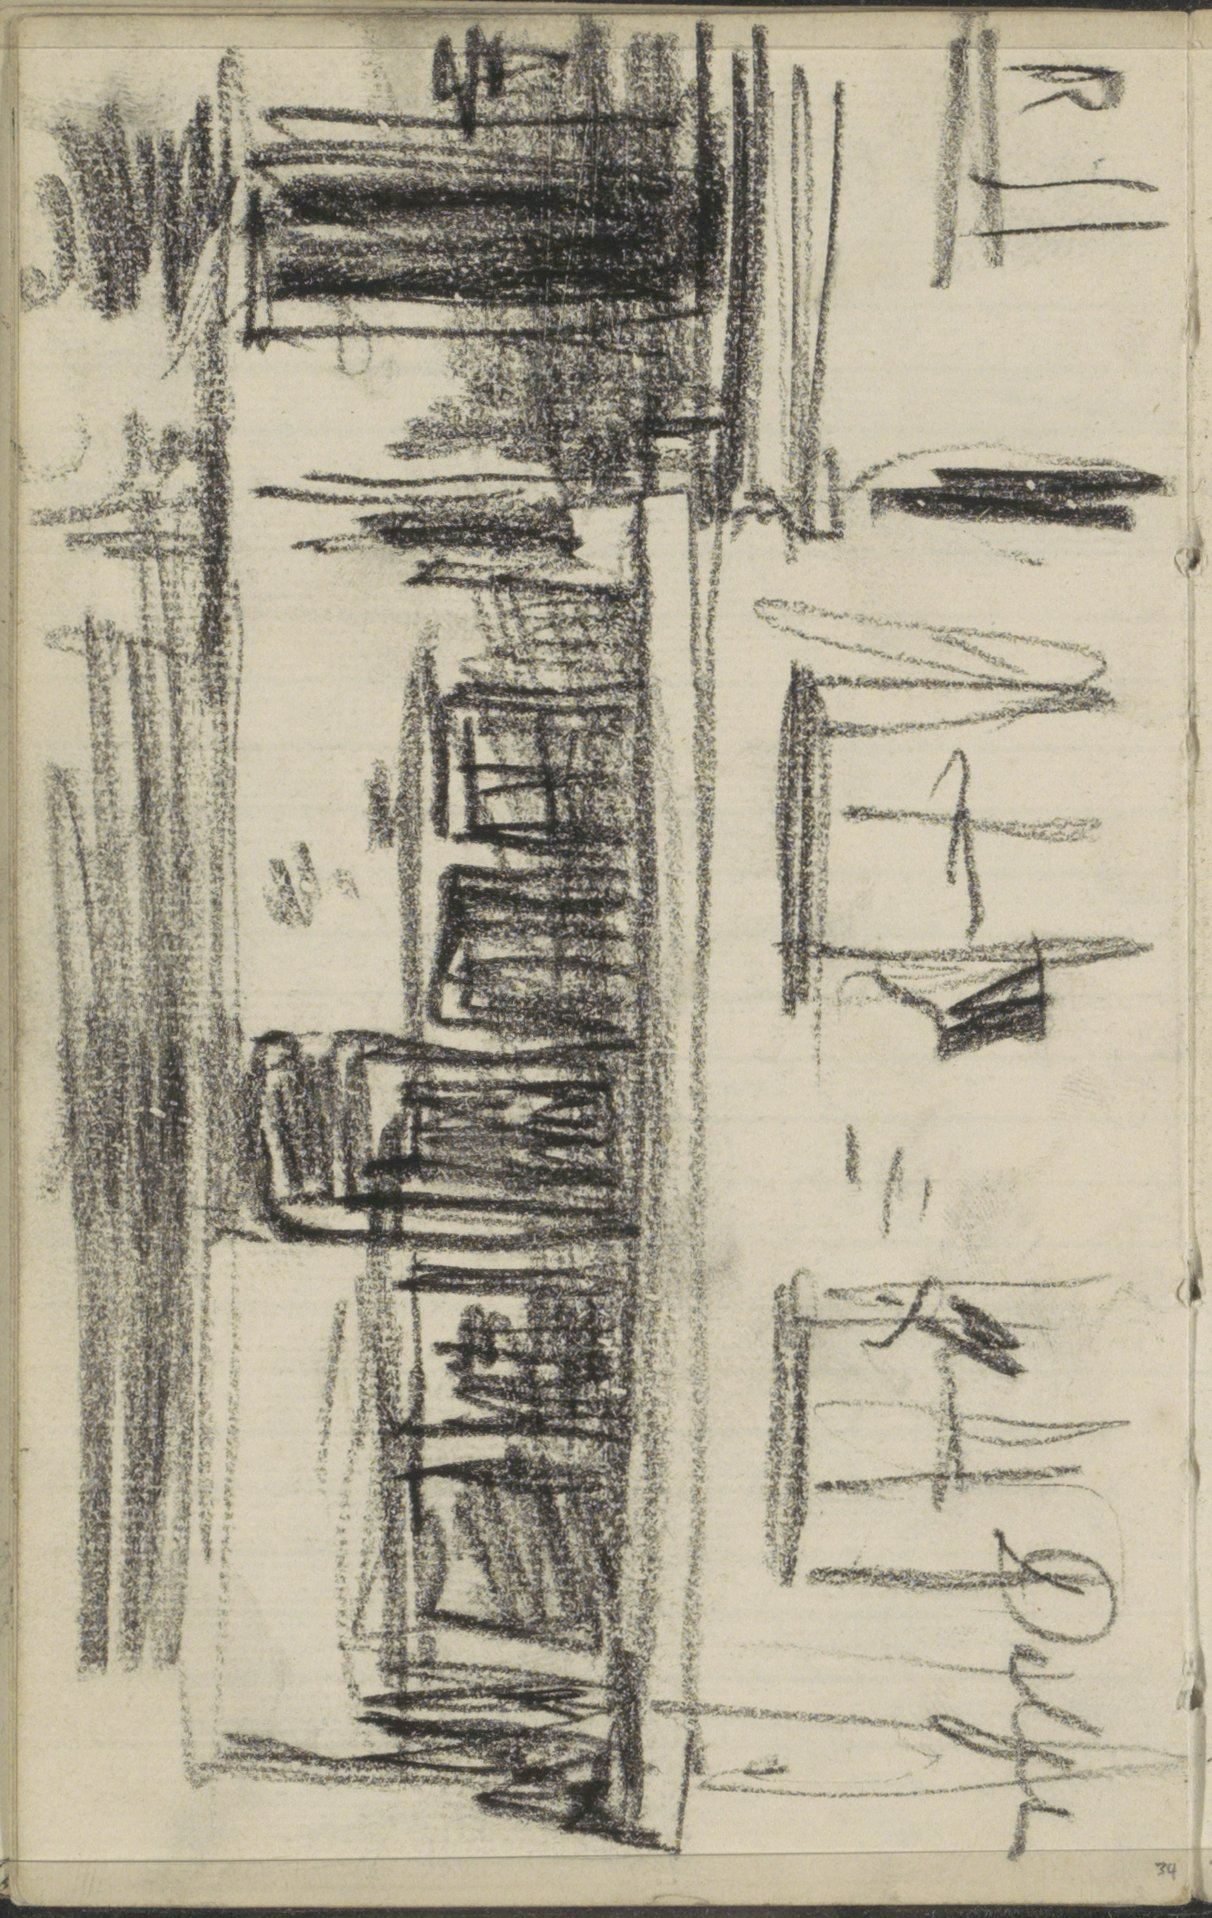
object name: sketchbook leaf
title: Gracht in Delft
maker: marius bauer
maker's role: draughtsman, print maker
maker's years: 1867-1932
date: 1881-1885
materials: chalk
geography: delft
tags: canals, waters (in city), street, delft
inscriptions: annotation: ‘Delft’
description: Pagina 34 uit een schetsboek met 26 bladen.